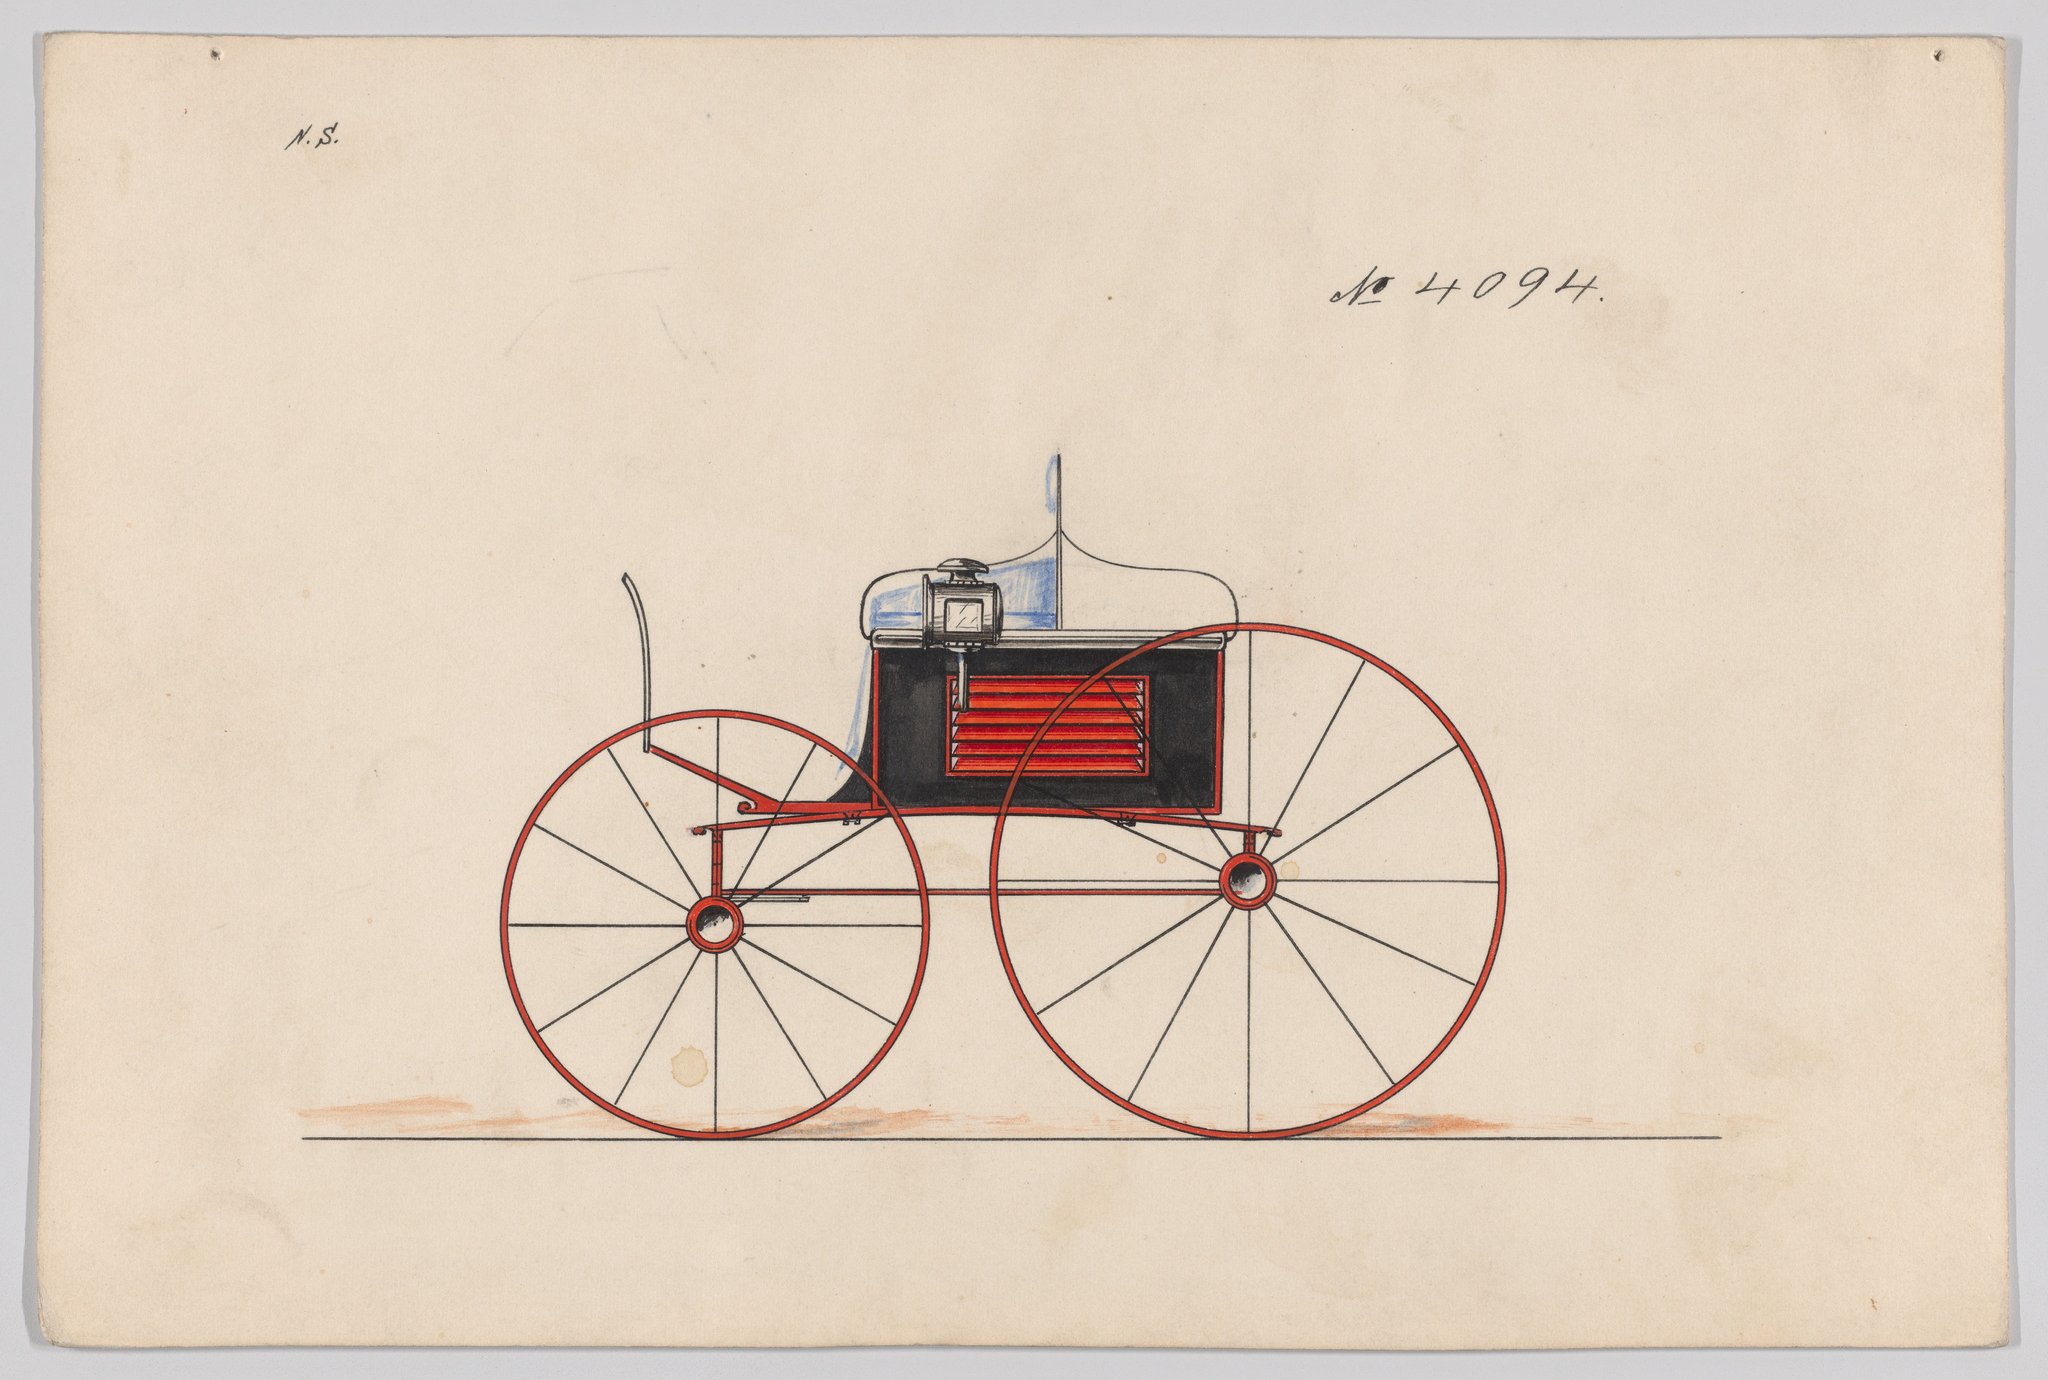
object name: drawing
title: Design for Dos-a-dos Phaeton, no. 4094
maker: brewster & co.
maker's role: manufacturer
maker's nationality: american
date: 1890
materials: gouache, gum arabic, ink, watercolor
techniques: pen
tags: carriages